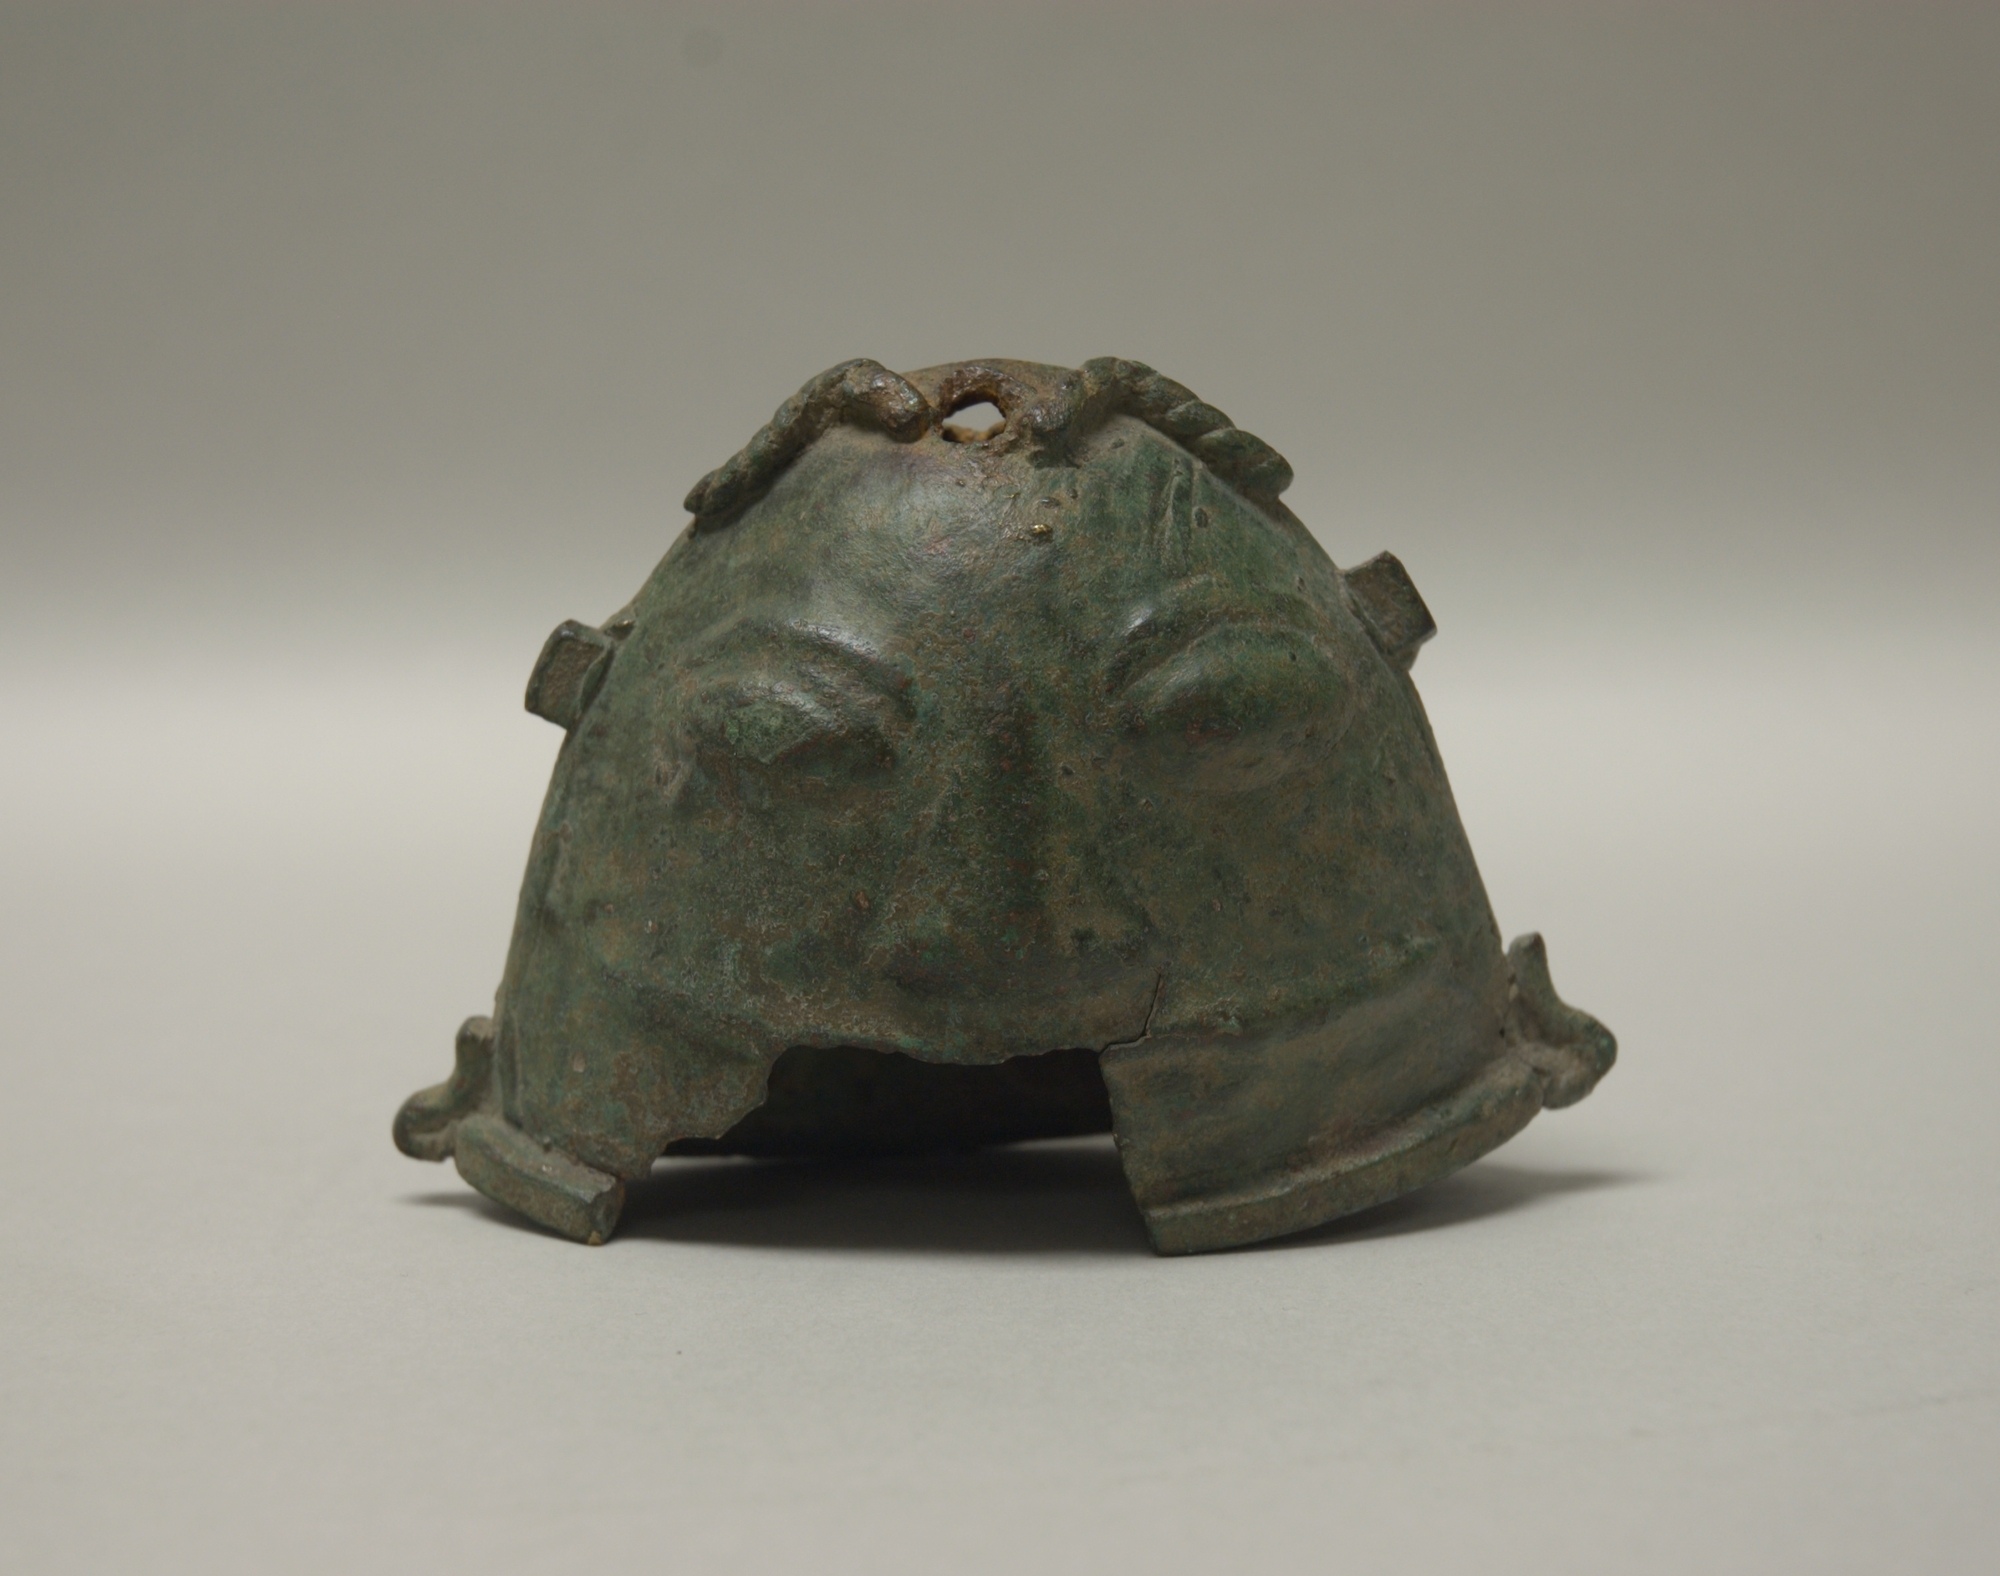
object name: bell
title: Bell with Anthropomorphic Face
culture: indonesian, javanese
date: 500 BCE-300 CE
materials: bronze